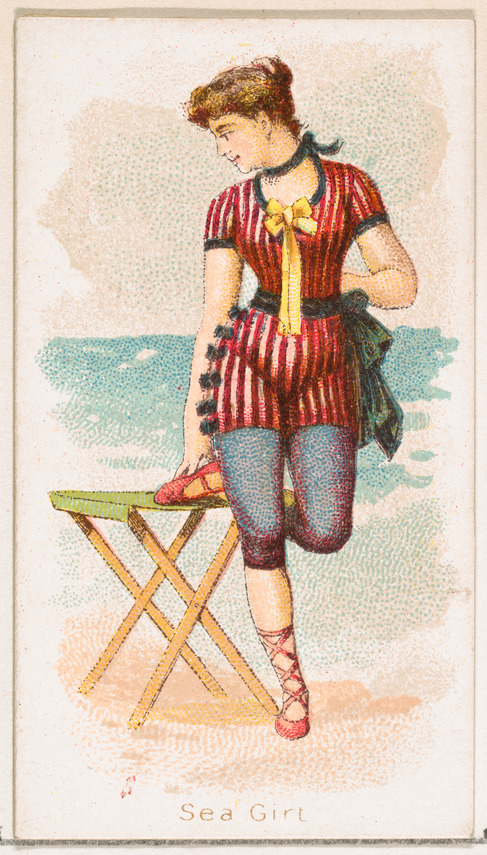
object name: print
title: Sea Girt, from the Fancy Bathers series (N187) issued by Wm. S. Kimball & Co.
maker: william s. kimball & company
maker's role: publisher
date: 1889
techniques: color lithograph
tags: profiles,women